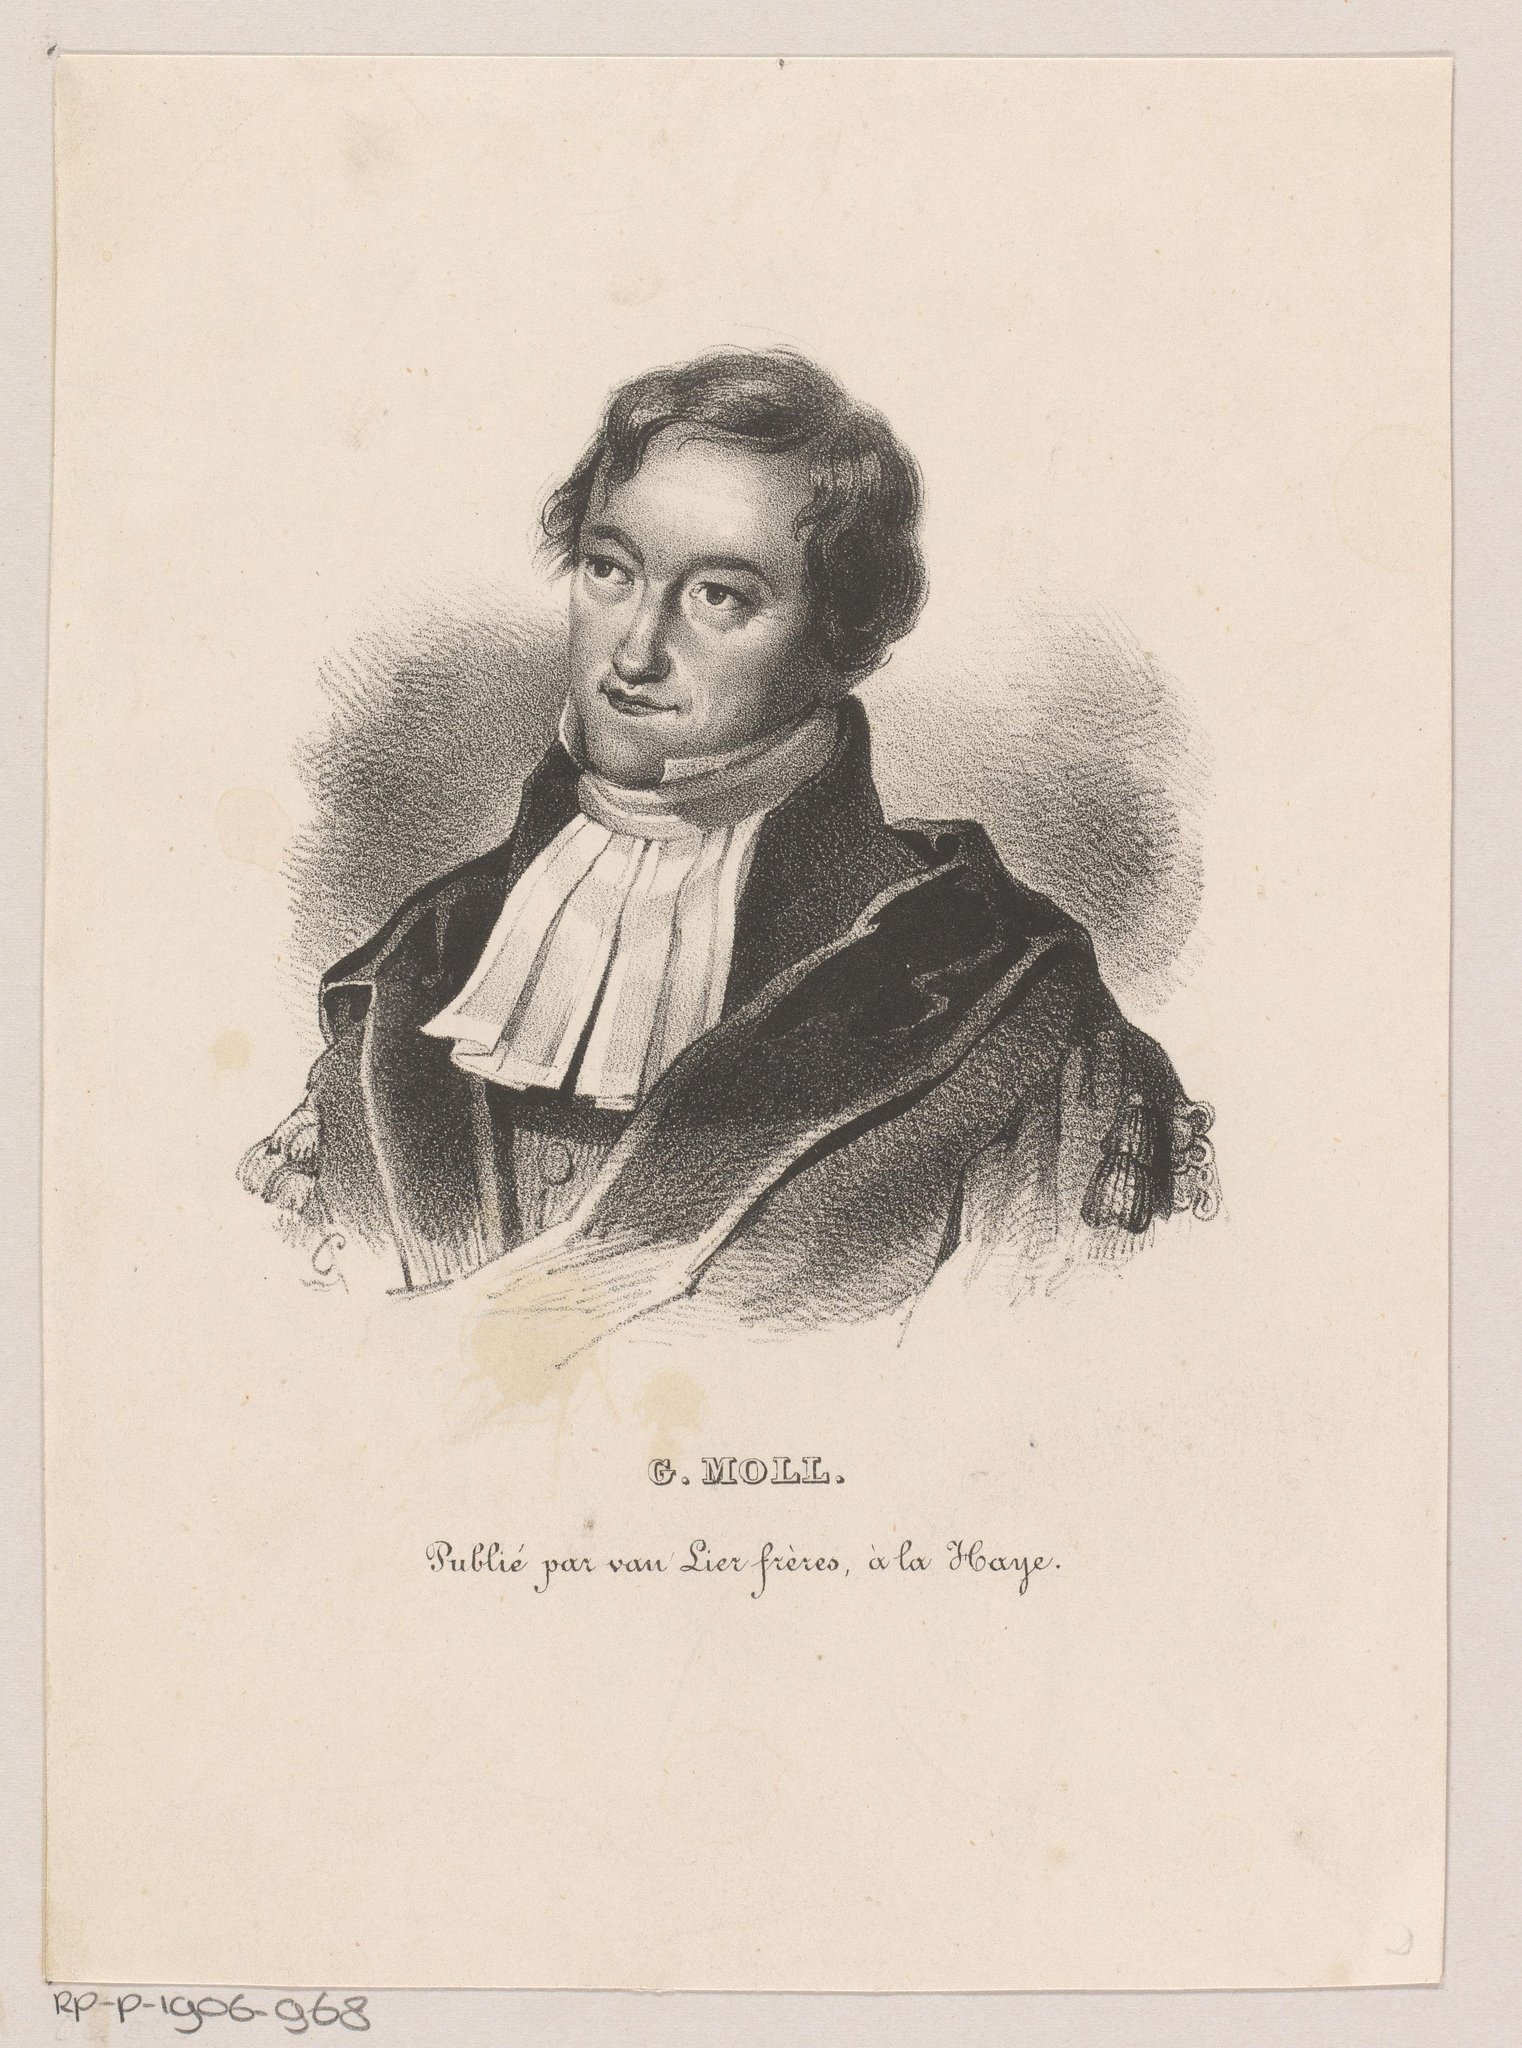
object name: print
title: G. Moll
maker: wilhelmus cornelis chimaer van oudendorp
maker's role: print maker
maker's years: 1822-1873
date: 1832-1873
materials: paper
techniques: lithograph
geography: the hague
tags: historical persons, professor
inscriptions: collector's mark: Lugt 2228